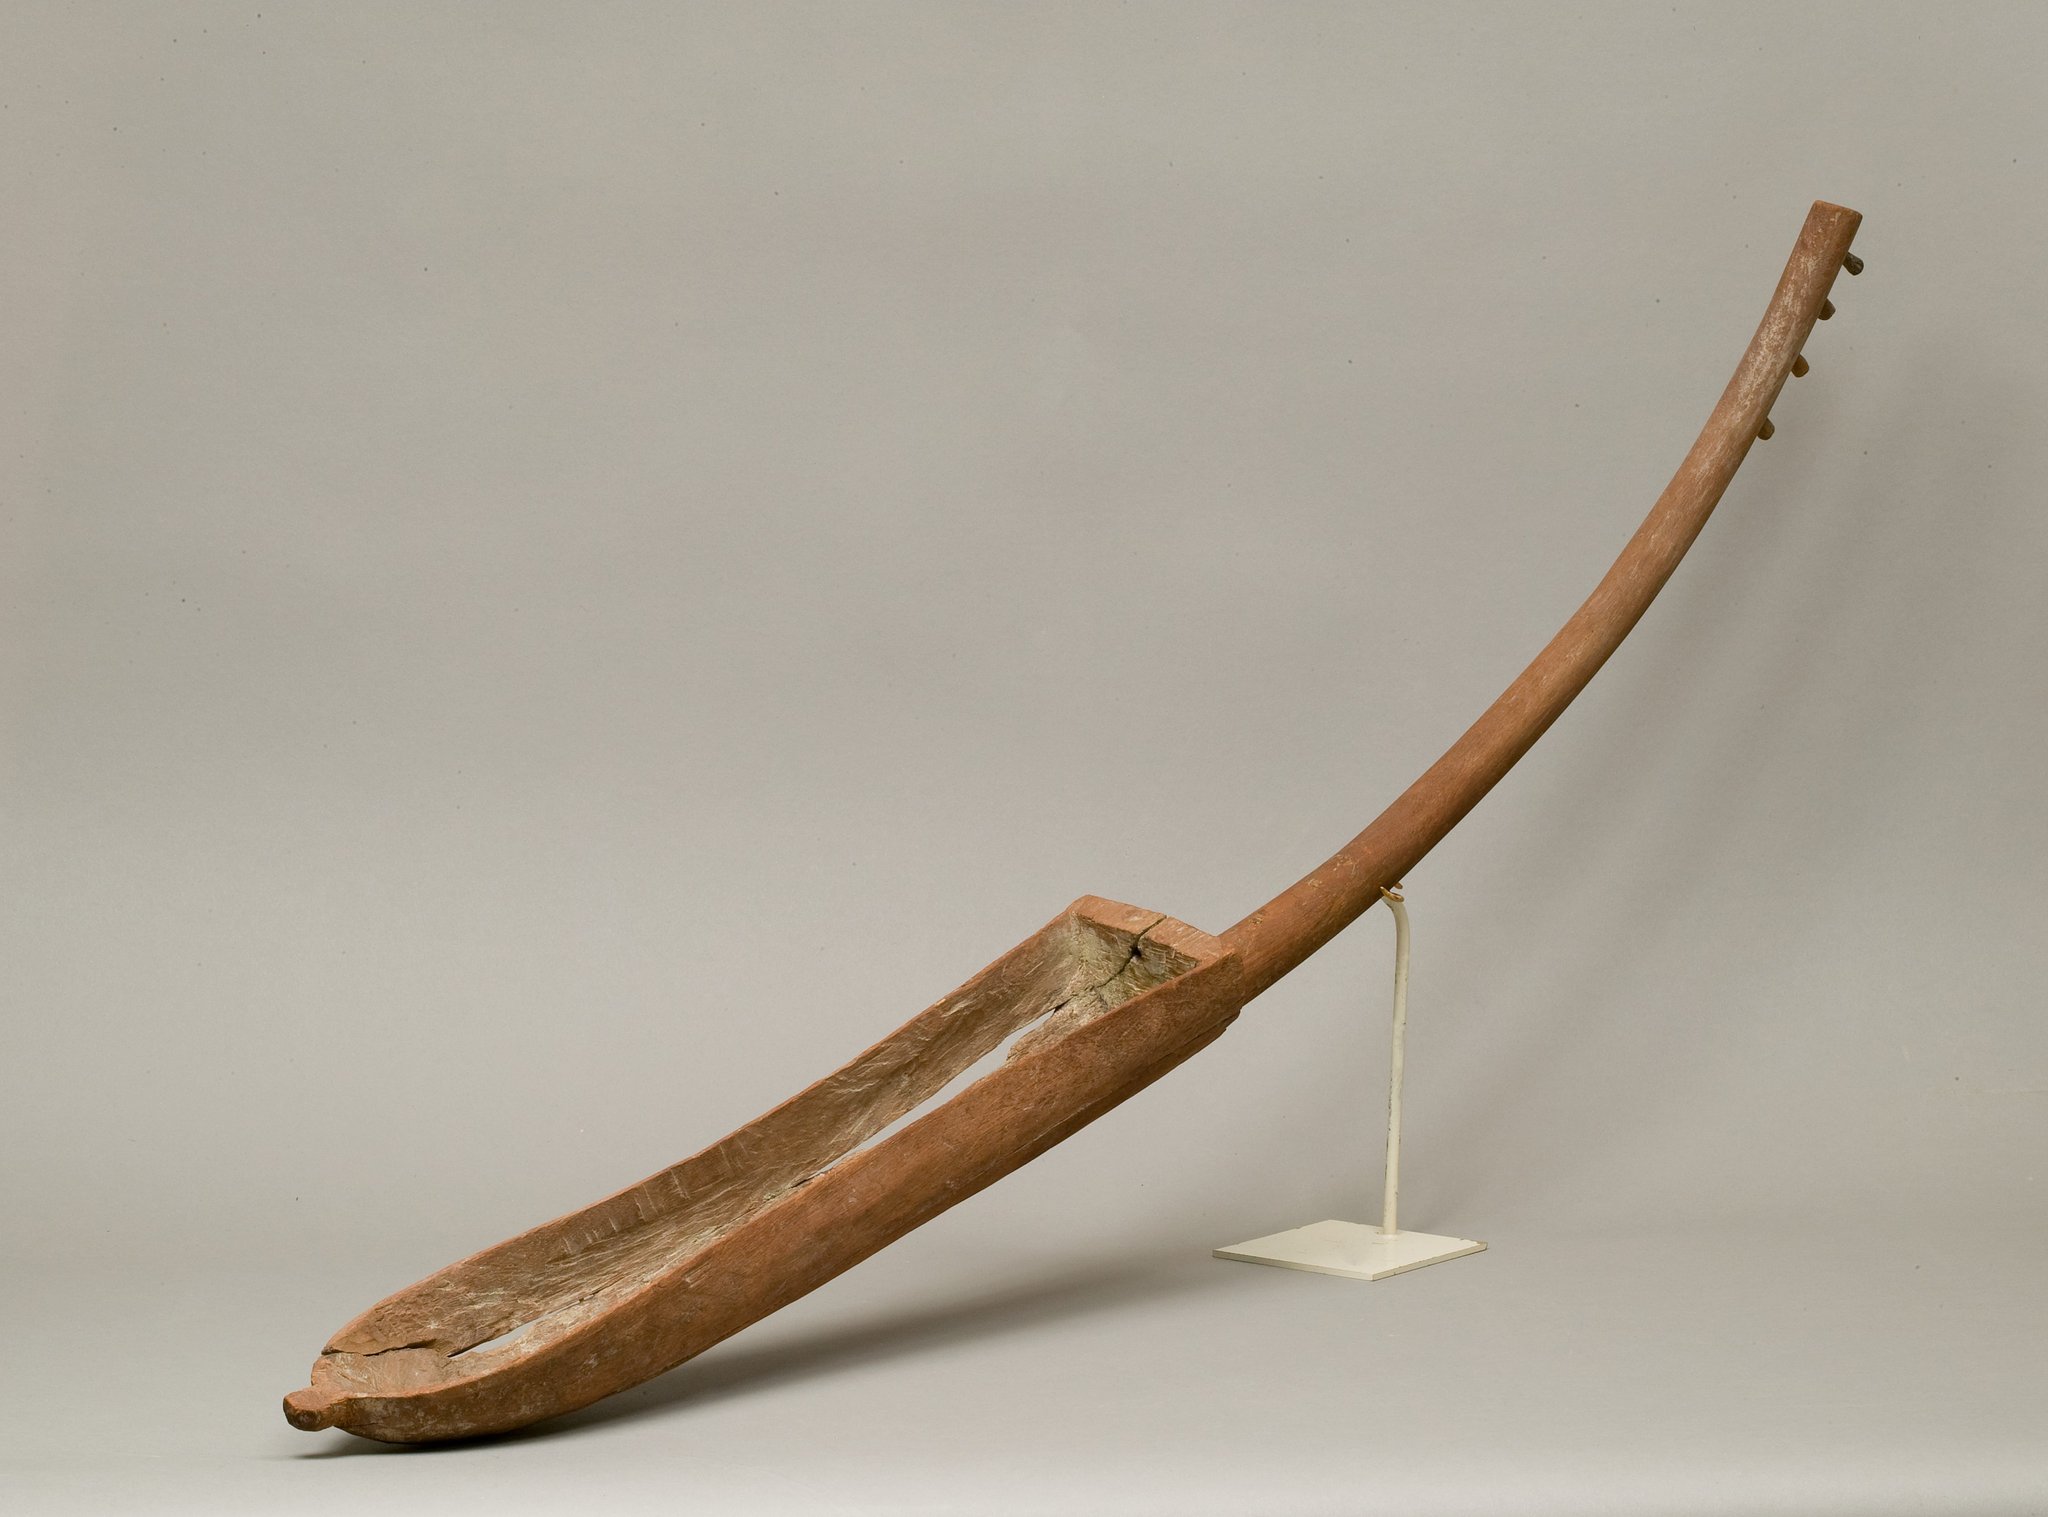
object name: music, harp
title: Harp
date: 1700-1450 BCE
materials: wood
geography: egypt